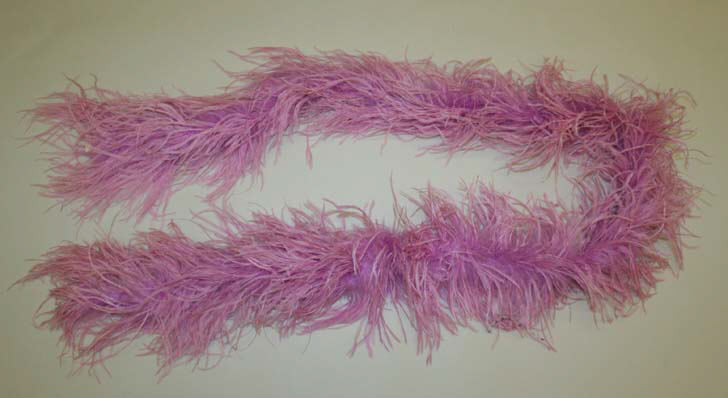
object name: boa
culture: american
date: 1890-1899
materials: feather